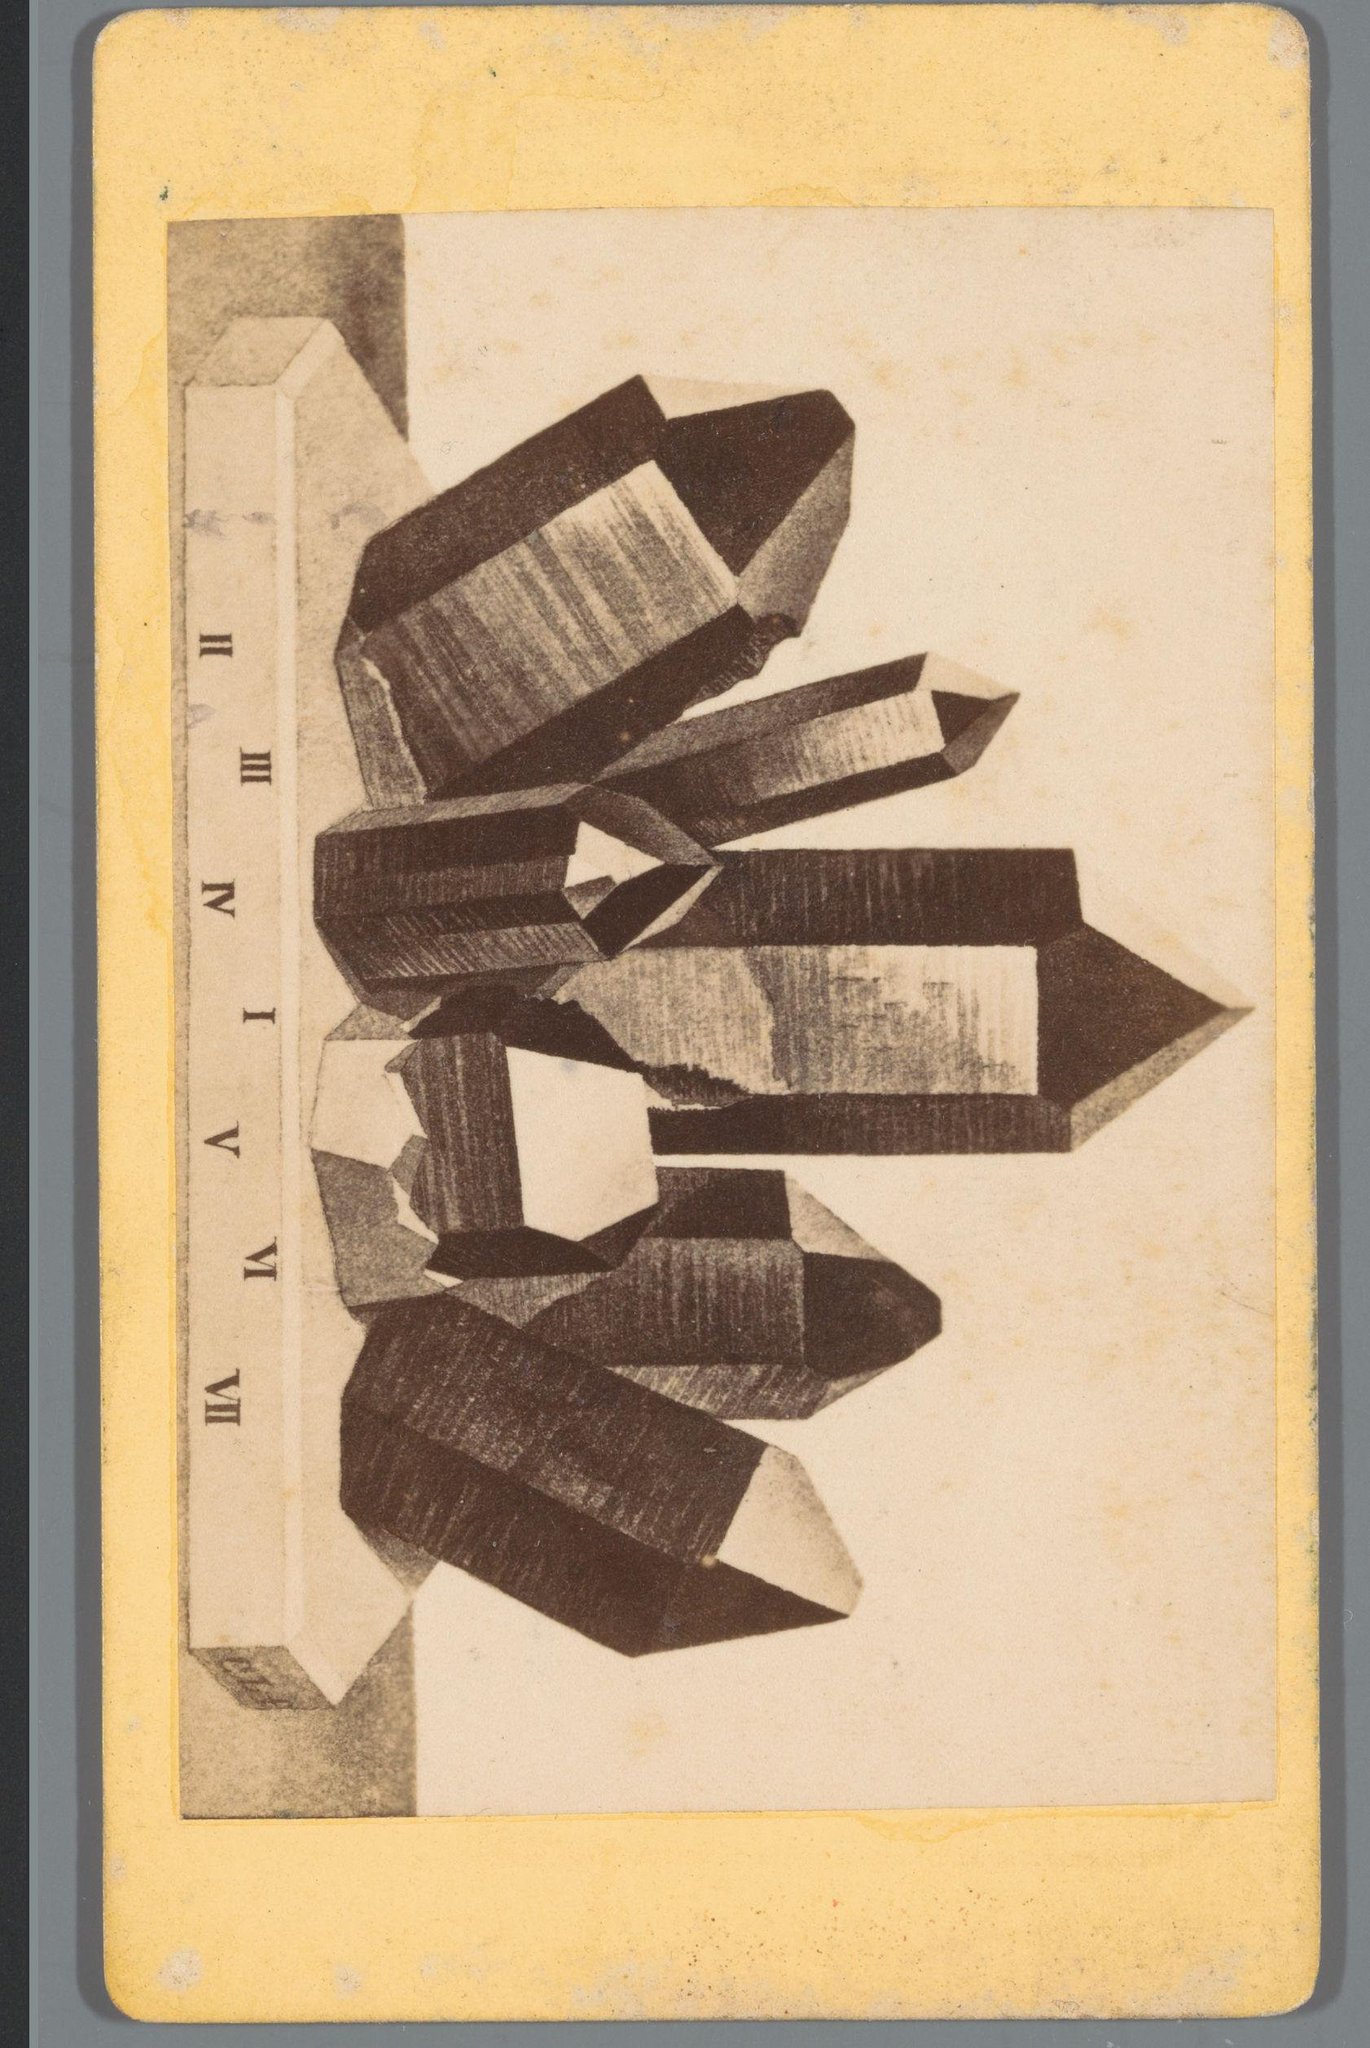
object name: carte de visite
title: Fotoreproductie van een ontwerp van bergkristallen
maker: Anonymous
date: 1869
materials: cardboard, paper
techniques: albumen print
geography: bern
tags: precious and semiprecious stones: rock-crystal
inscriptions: inscription: ‘Geschenk des Herrn Friedrich Bürcki. 1869.’, inscription: ‘I. Der König, Höhe: 87 Cm. (...) Umfg.: 77 Cm., Gew.: 125 Pfd.’